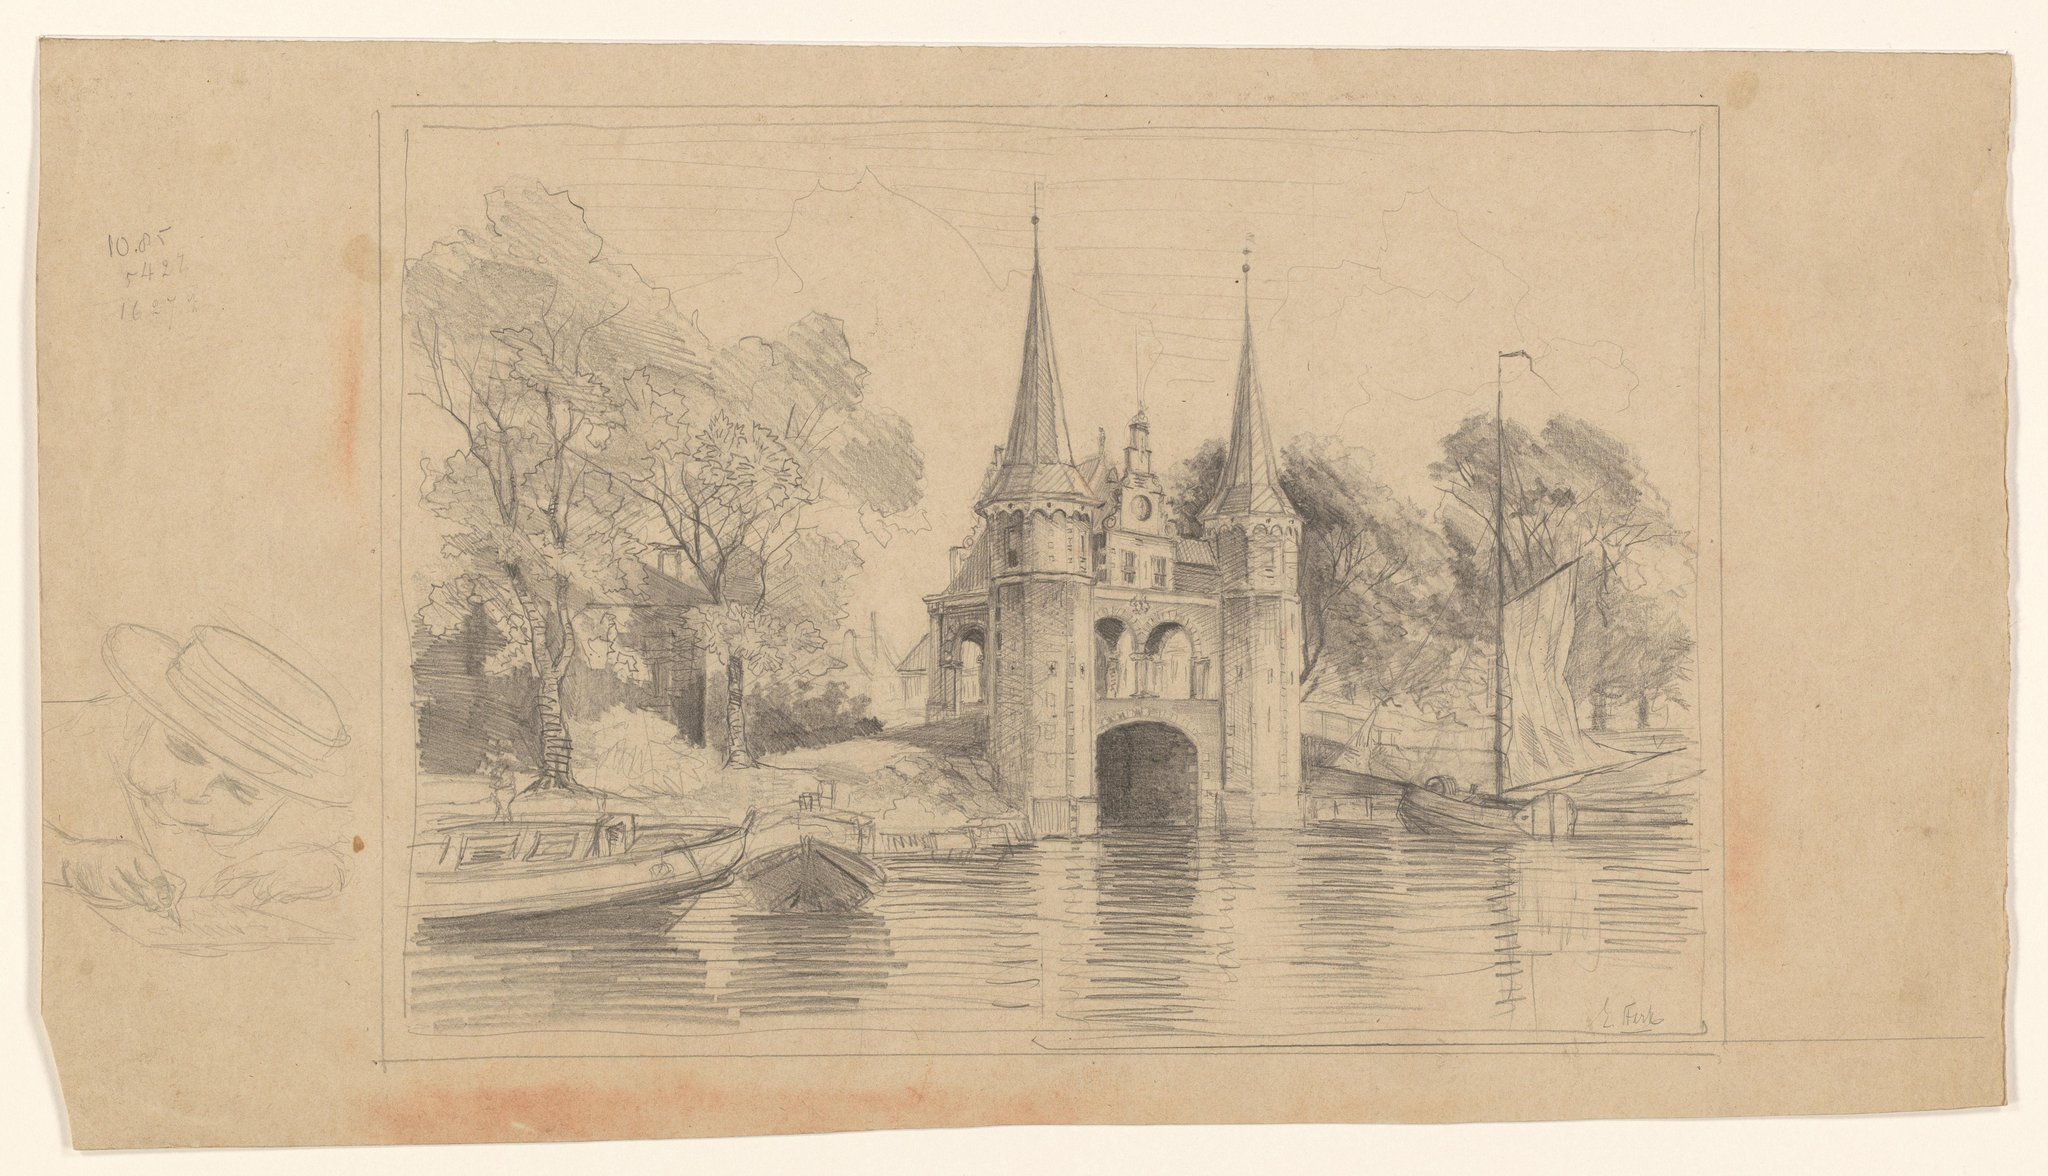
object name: drawing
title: Gezicht op de Waterpoort te Sneek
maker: elias stark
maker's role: draughtsman, print maker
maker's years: 1849-1933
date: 1859-1933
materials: paper, pencil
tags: city-gate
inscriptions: inscription: ‘Waterpoort te Sneek’, annotation: ‘10.85/ 5421/ 1627 2 ’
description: Buiten het kader links een tekenende of schrijvende figuur met hoed.